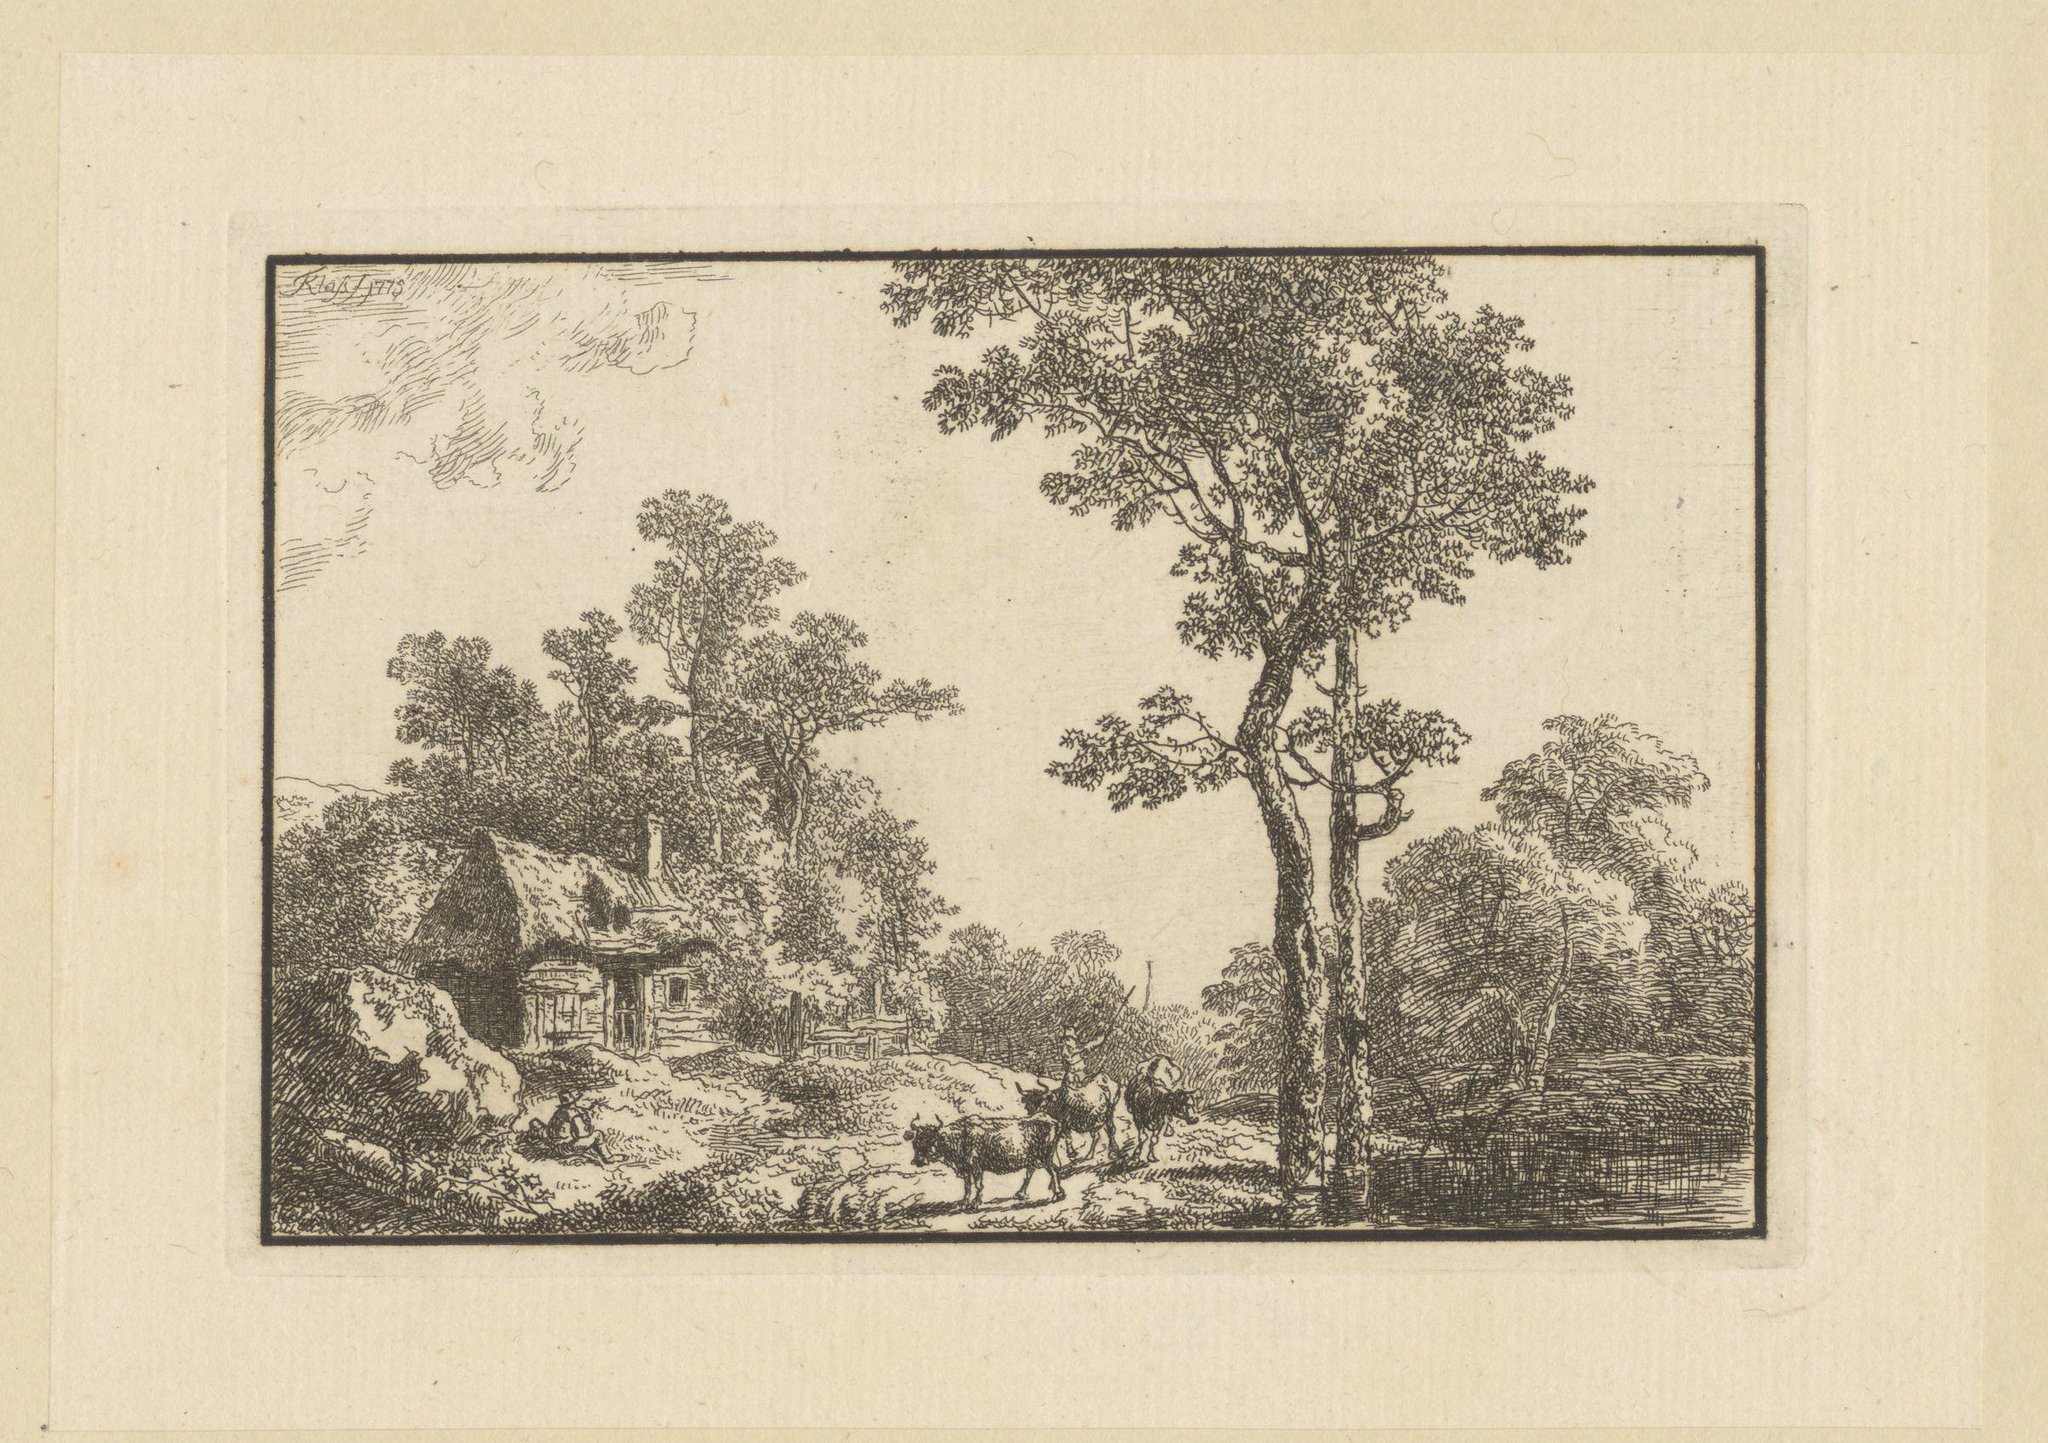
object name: print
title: Landschap met hut en herder met runderen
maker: friedrich christian klass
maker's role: painter, print maker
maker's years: 1752-1827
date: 1775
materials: paper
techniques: etching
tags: low hill country, (traveller) resting in the open air, cattle driving, cattle driver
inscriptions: collector's mark: Lugt 240